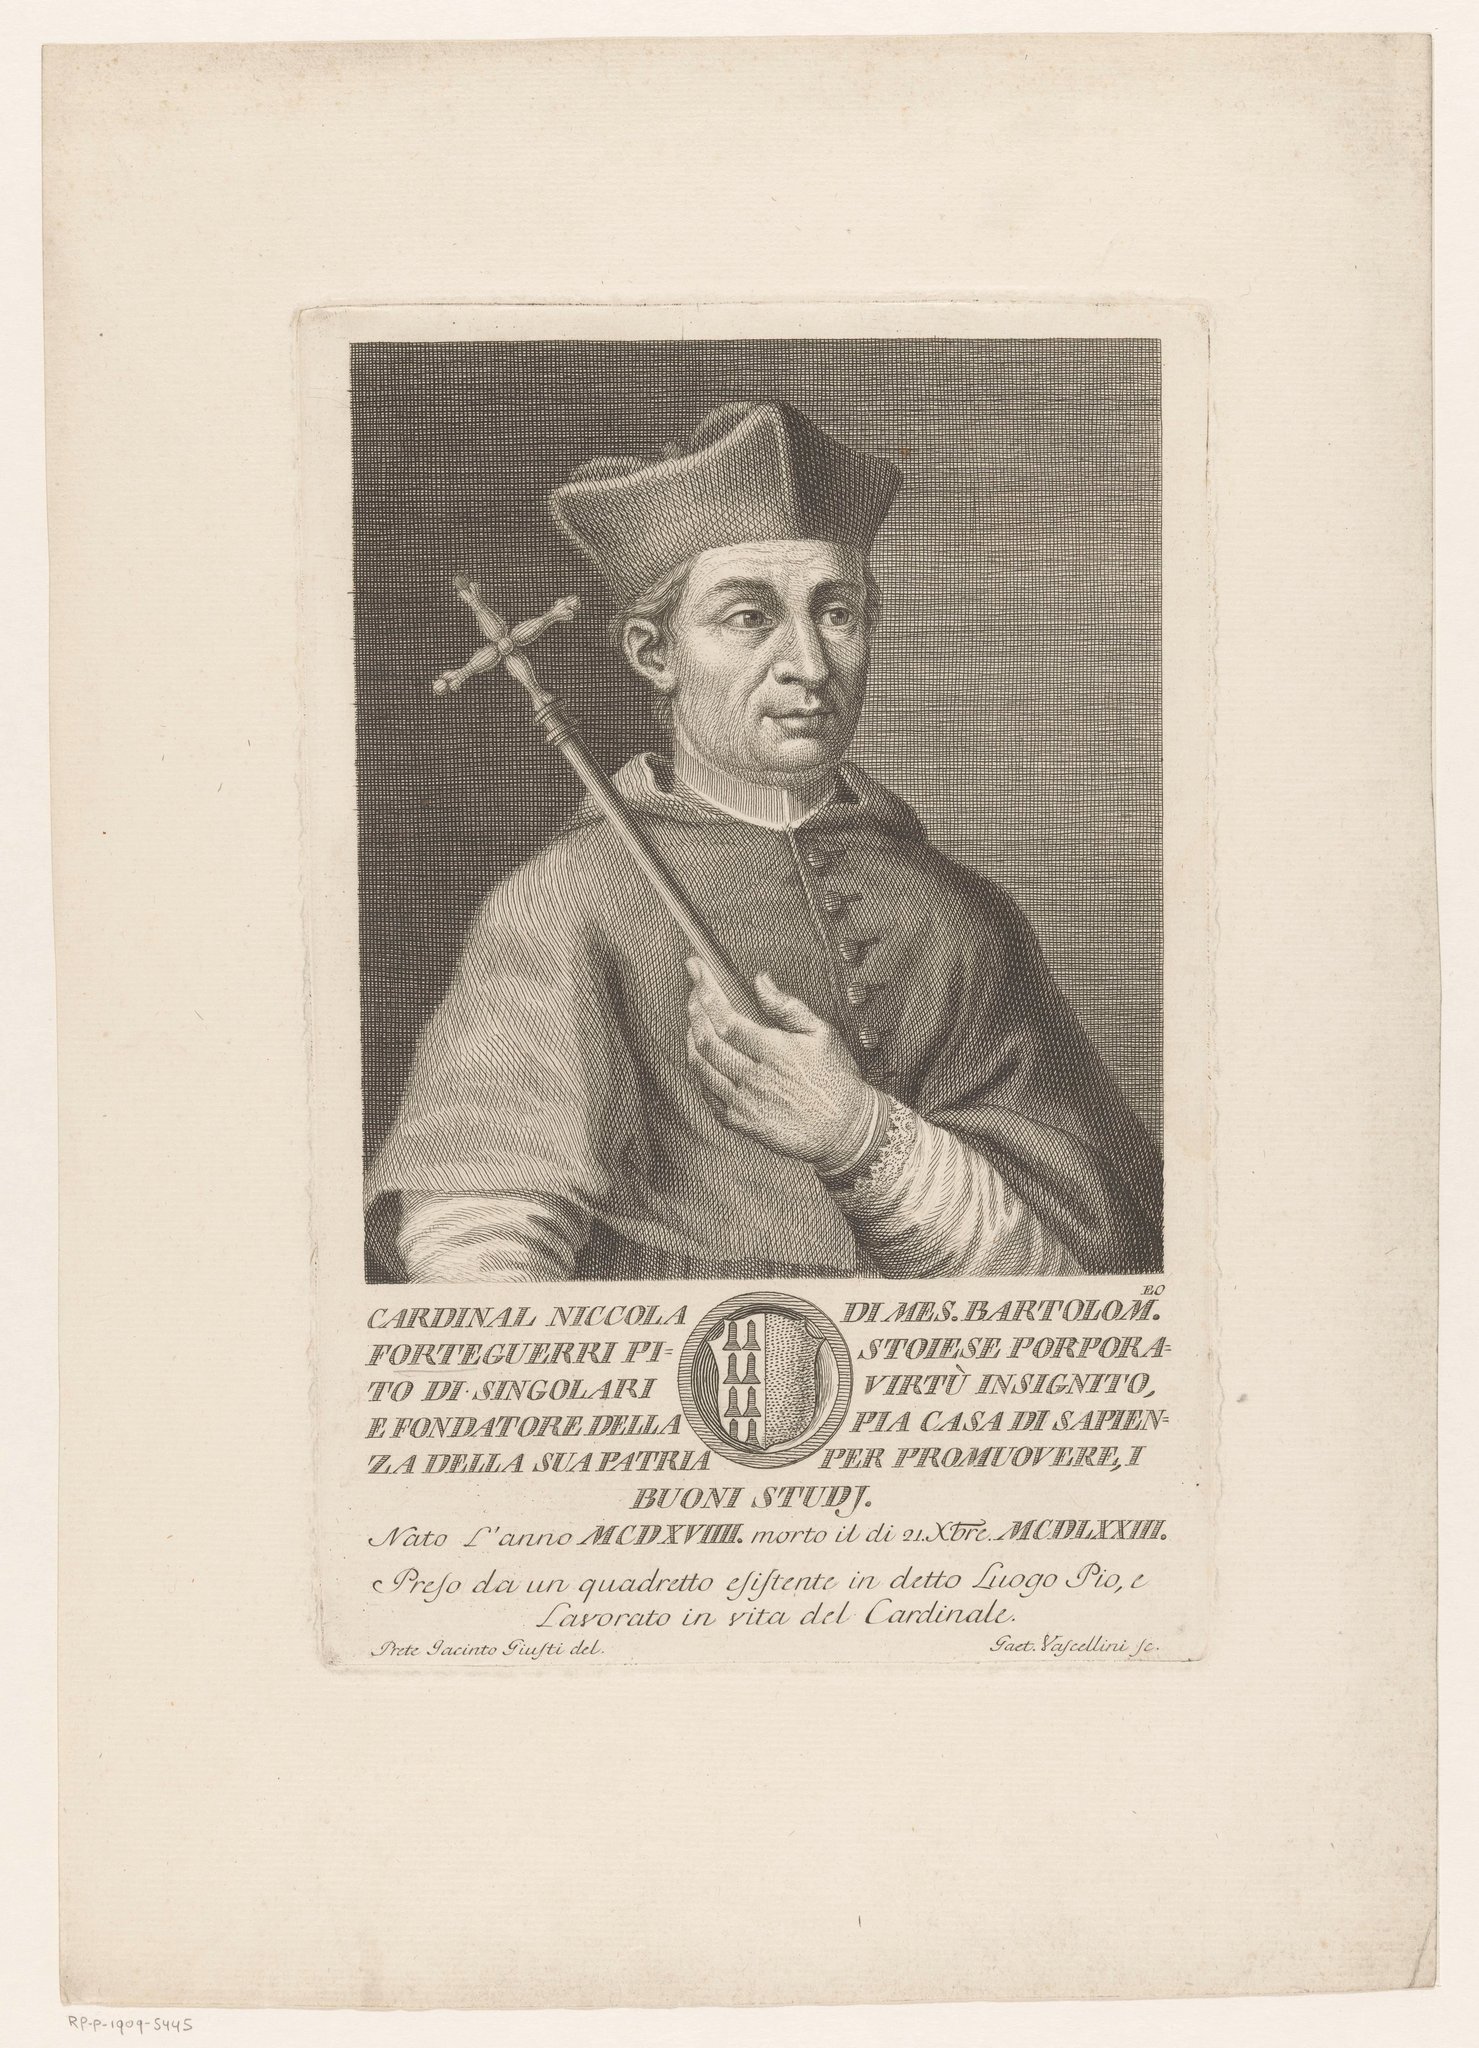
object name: print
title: Portret van kardinaal Niccolò Fortiguerra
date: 1755-1805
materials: paper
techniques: engraving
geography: italy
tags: historical persons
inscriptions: collector's mark: Lugt 2228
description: Onder het portret een tekst in het Italiaans en een wapenschild in een cirkelvormig kader.